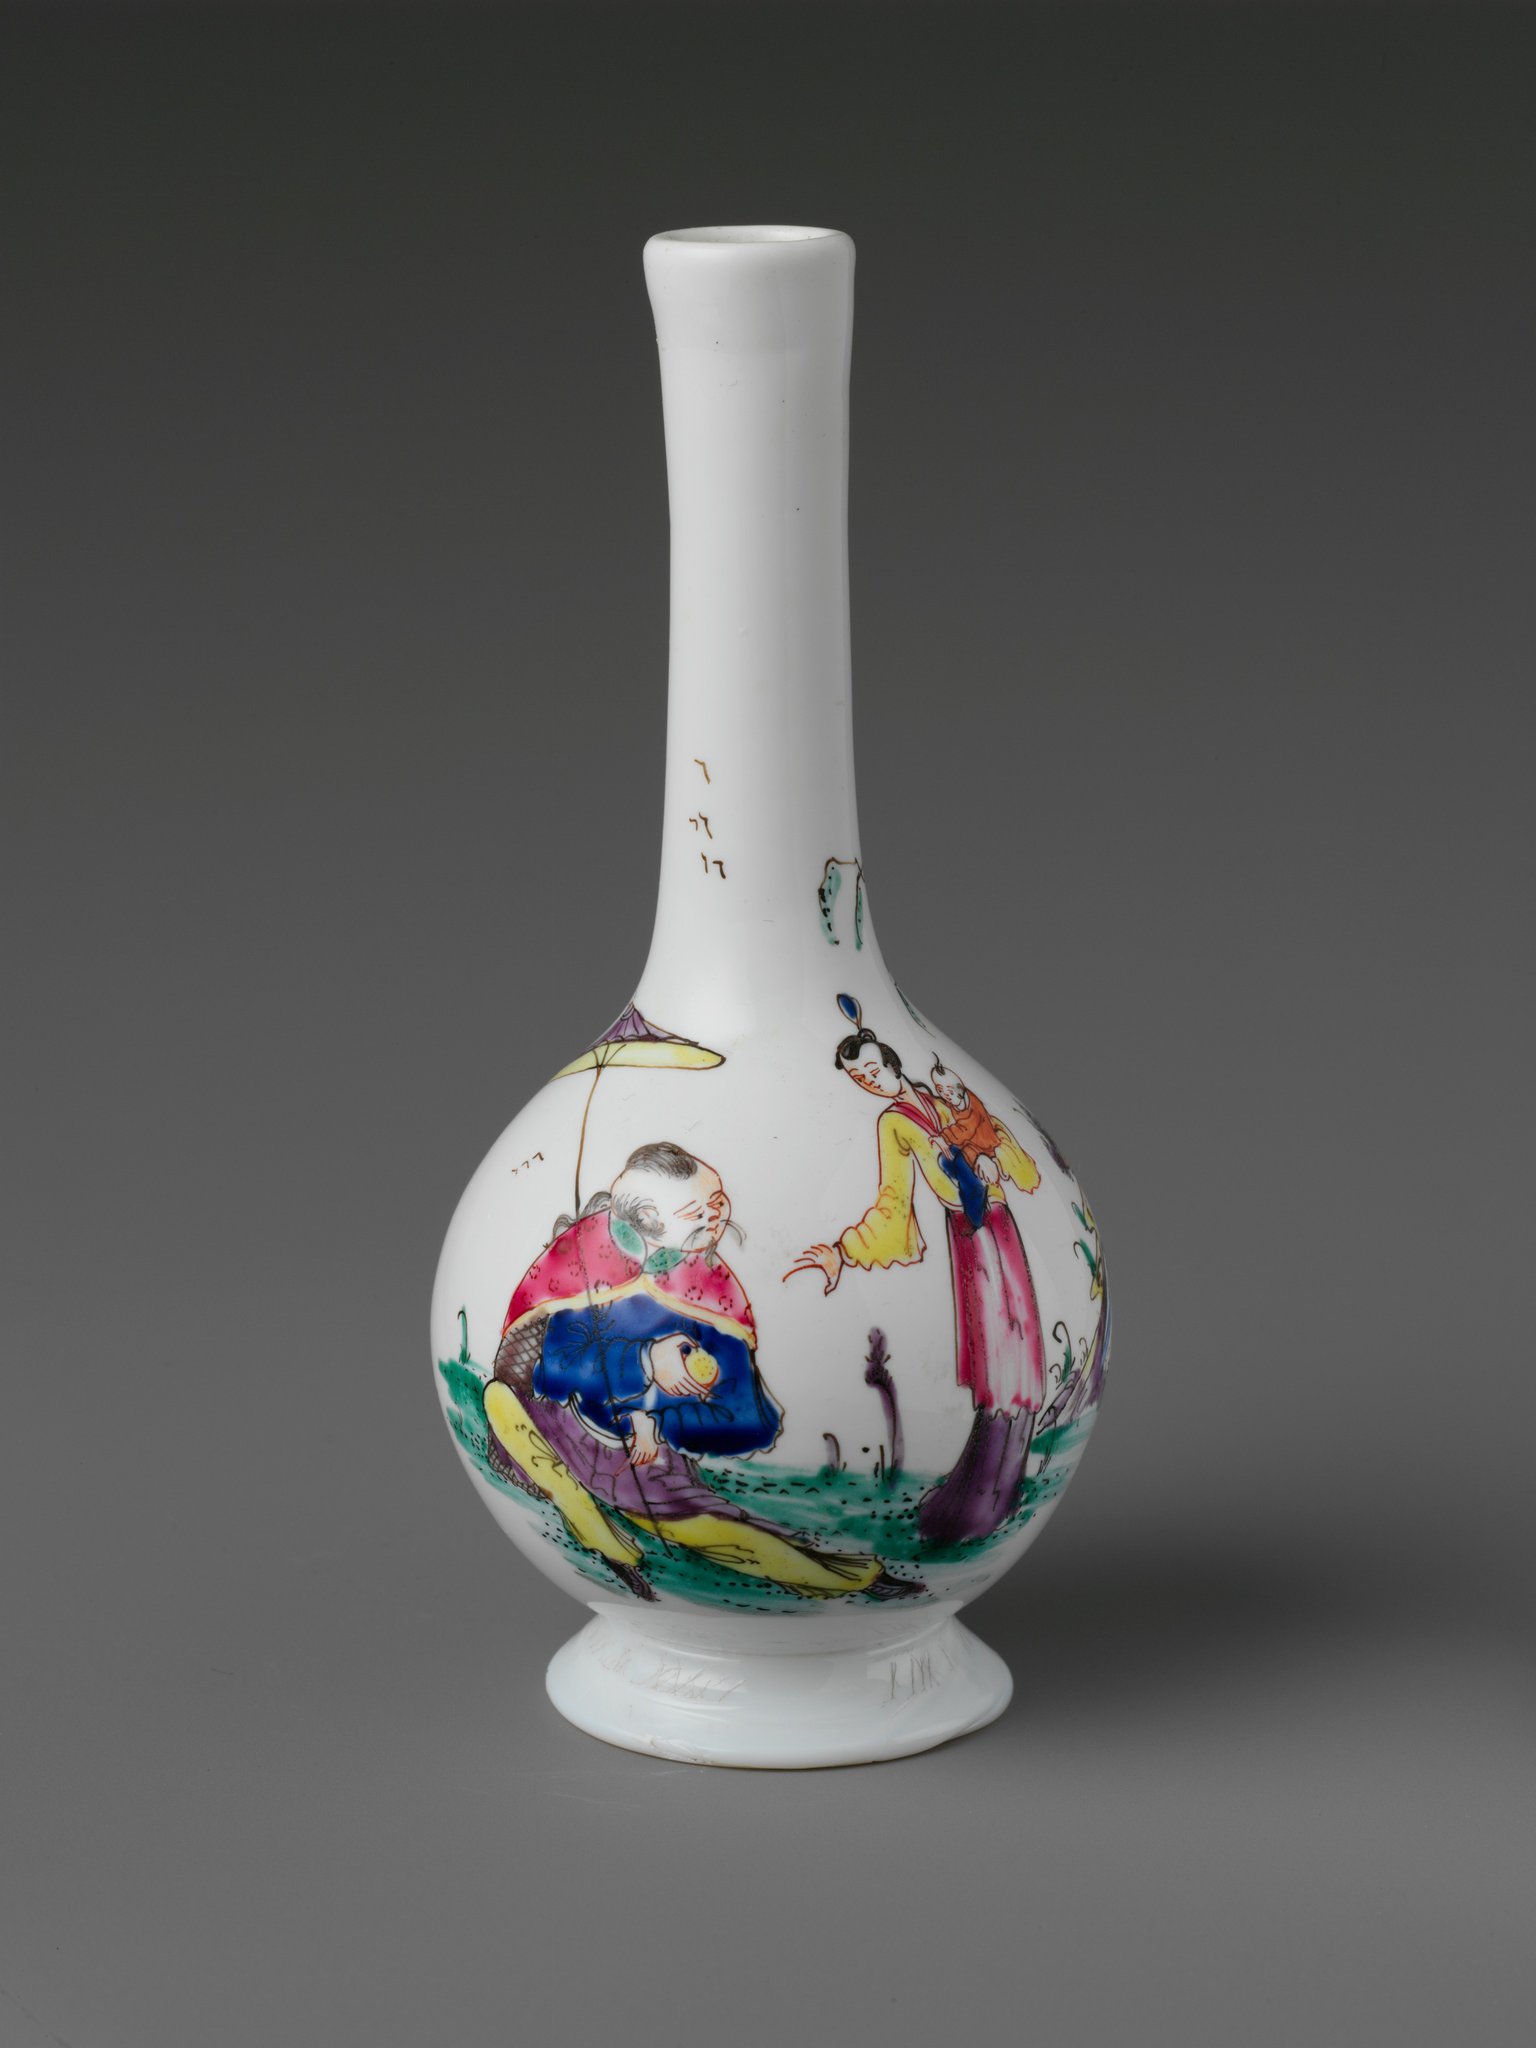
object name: bottle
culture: british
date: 1760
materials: enamel, glass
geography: england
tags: children,men,women